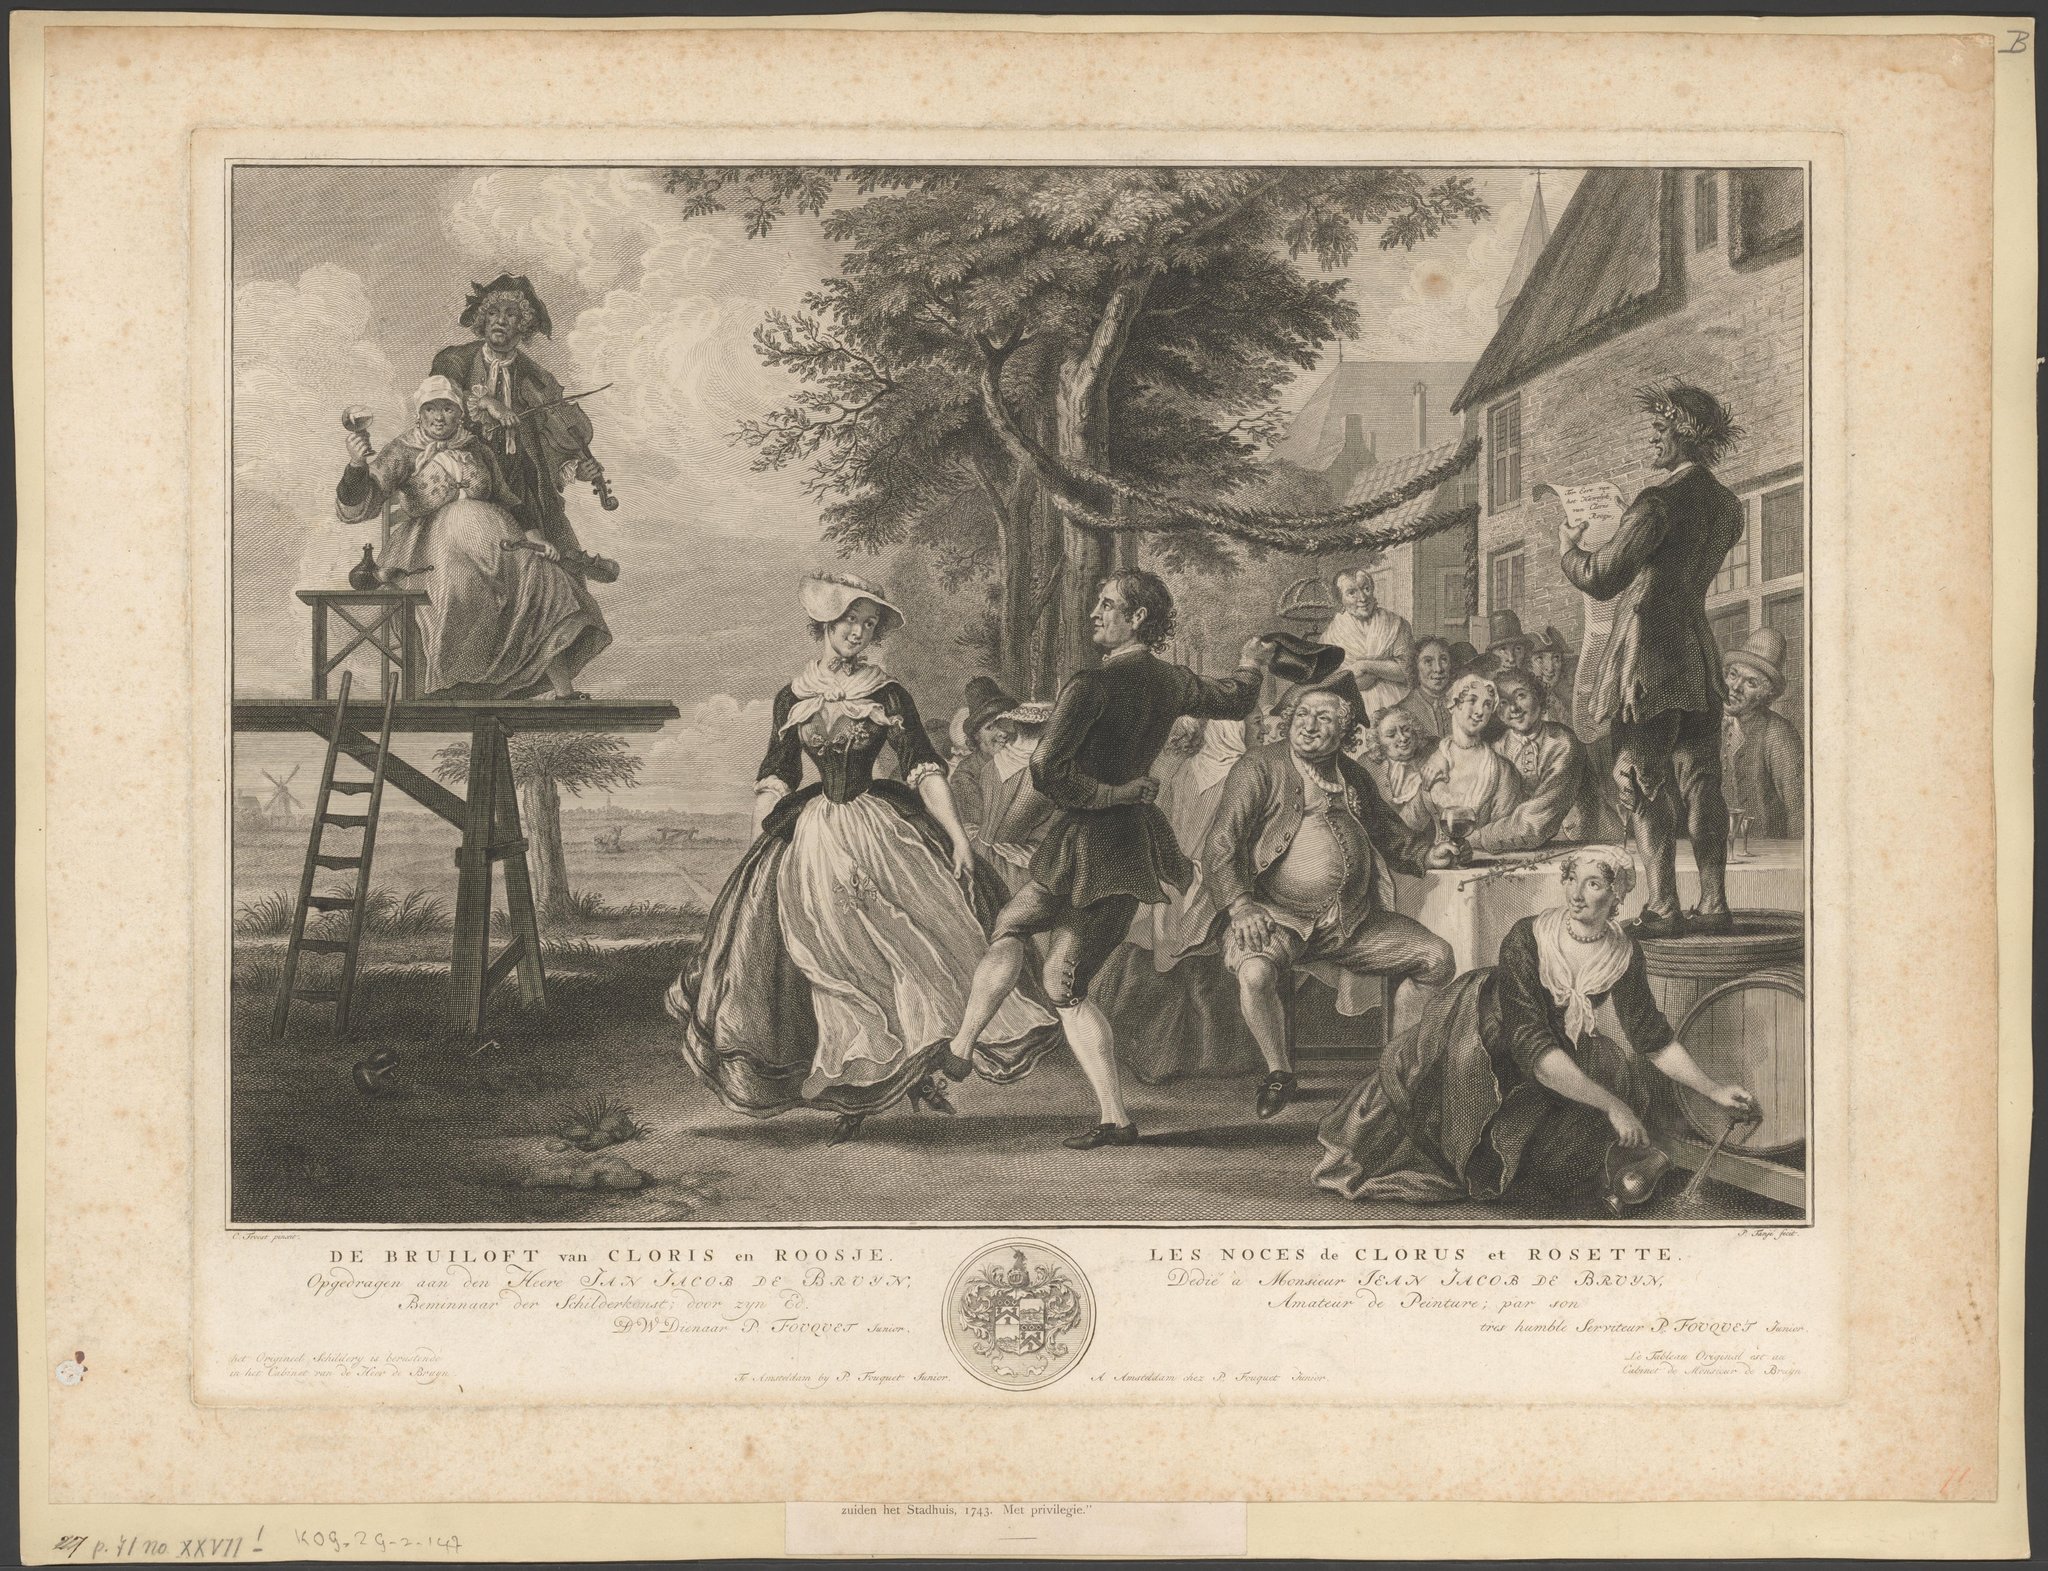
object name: print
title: De bruiloft van Cloris en Roosje / Les noces de Clorus et Rosette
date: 1754-1764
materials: paper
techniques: engraving, etching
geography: amsterdam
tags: wooden container: barrel, cask, bucket, violin, fiddle, one pair dancing; man and woman dancing as a couple, dancing at wedding feast - dd - out of doors, comedy, person addressing a group, orator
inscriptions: collector's mark: Lugt 2488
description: Cloris en Roosje dansen op hun bruiloft. Op de verhoging twee vioolspelers, van wie de vrouw het glas heft. Rechts de feestgangers en een man, die vanaf een ton een toespraak houdt. Onderaan in de marge het wapenschild van en een opdracht aan Jan Jacob de Bruyn, die het originele schilderij in zijn verzameling had. Scène uit het zangspel De bruiloft van Cloris en Roosje.